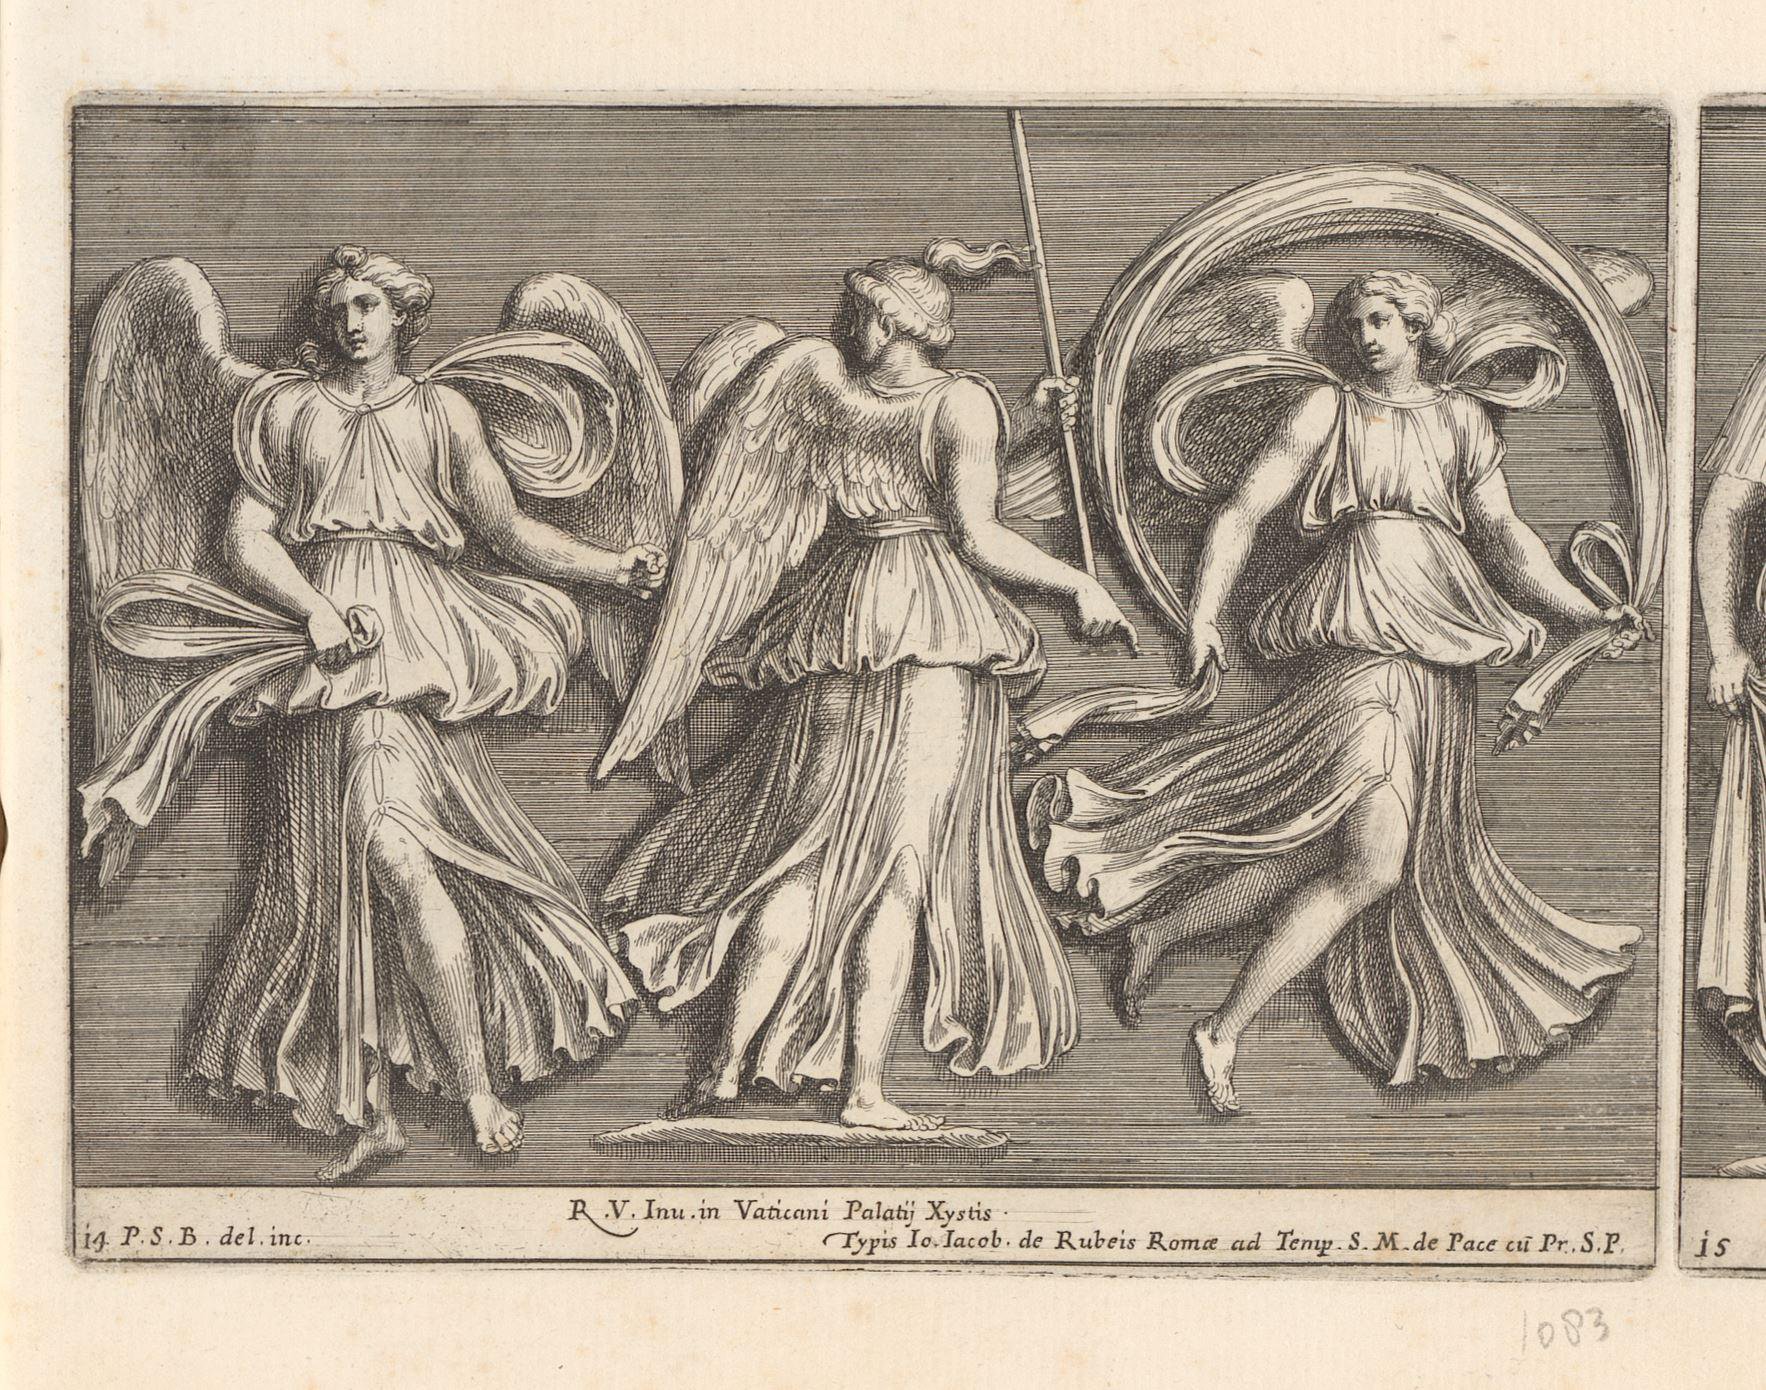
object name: print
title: Reliëfs in de Loggia van Rafaël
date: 1645-1700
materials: paper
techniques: engraving, etching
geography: vatican city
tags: angels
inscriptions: number: ‘43’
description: Prent uit een reeks naar de gipsen reliëfs door Rafaël en uitgevoerd door zijn assistenten in de Vaticaanse Loggia.